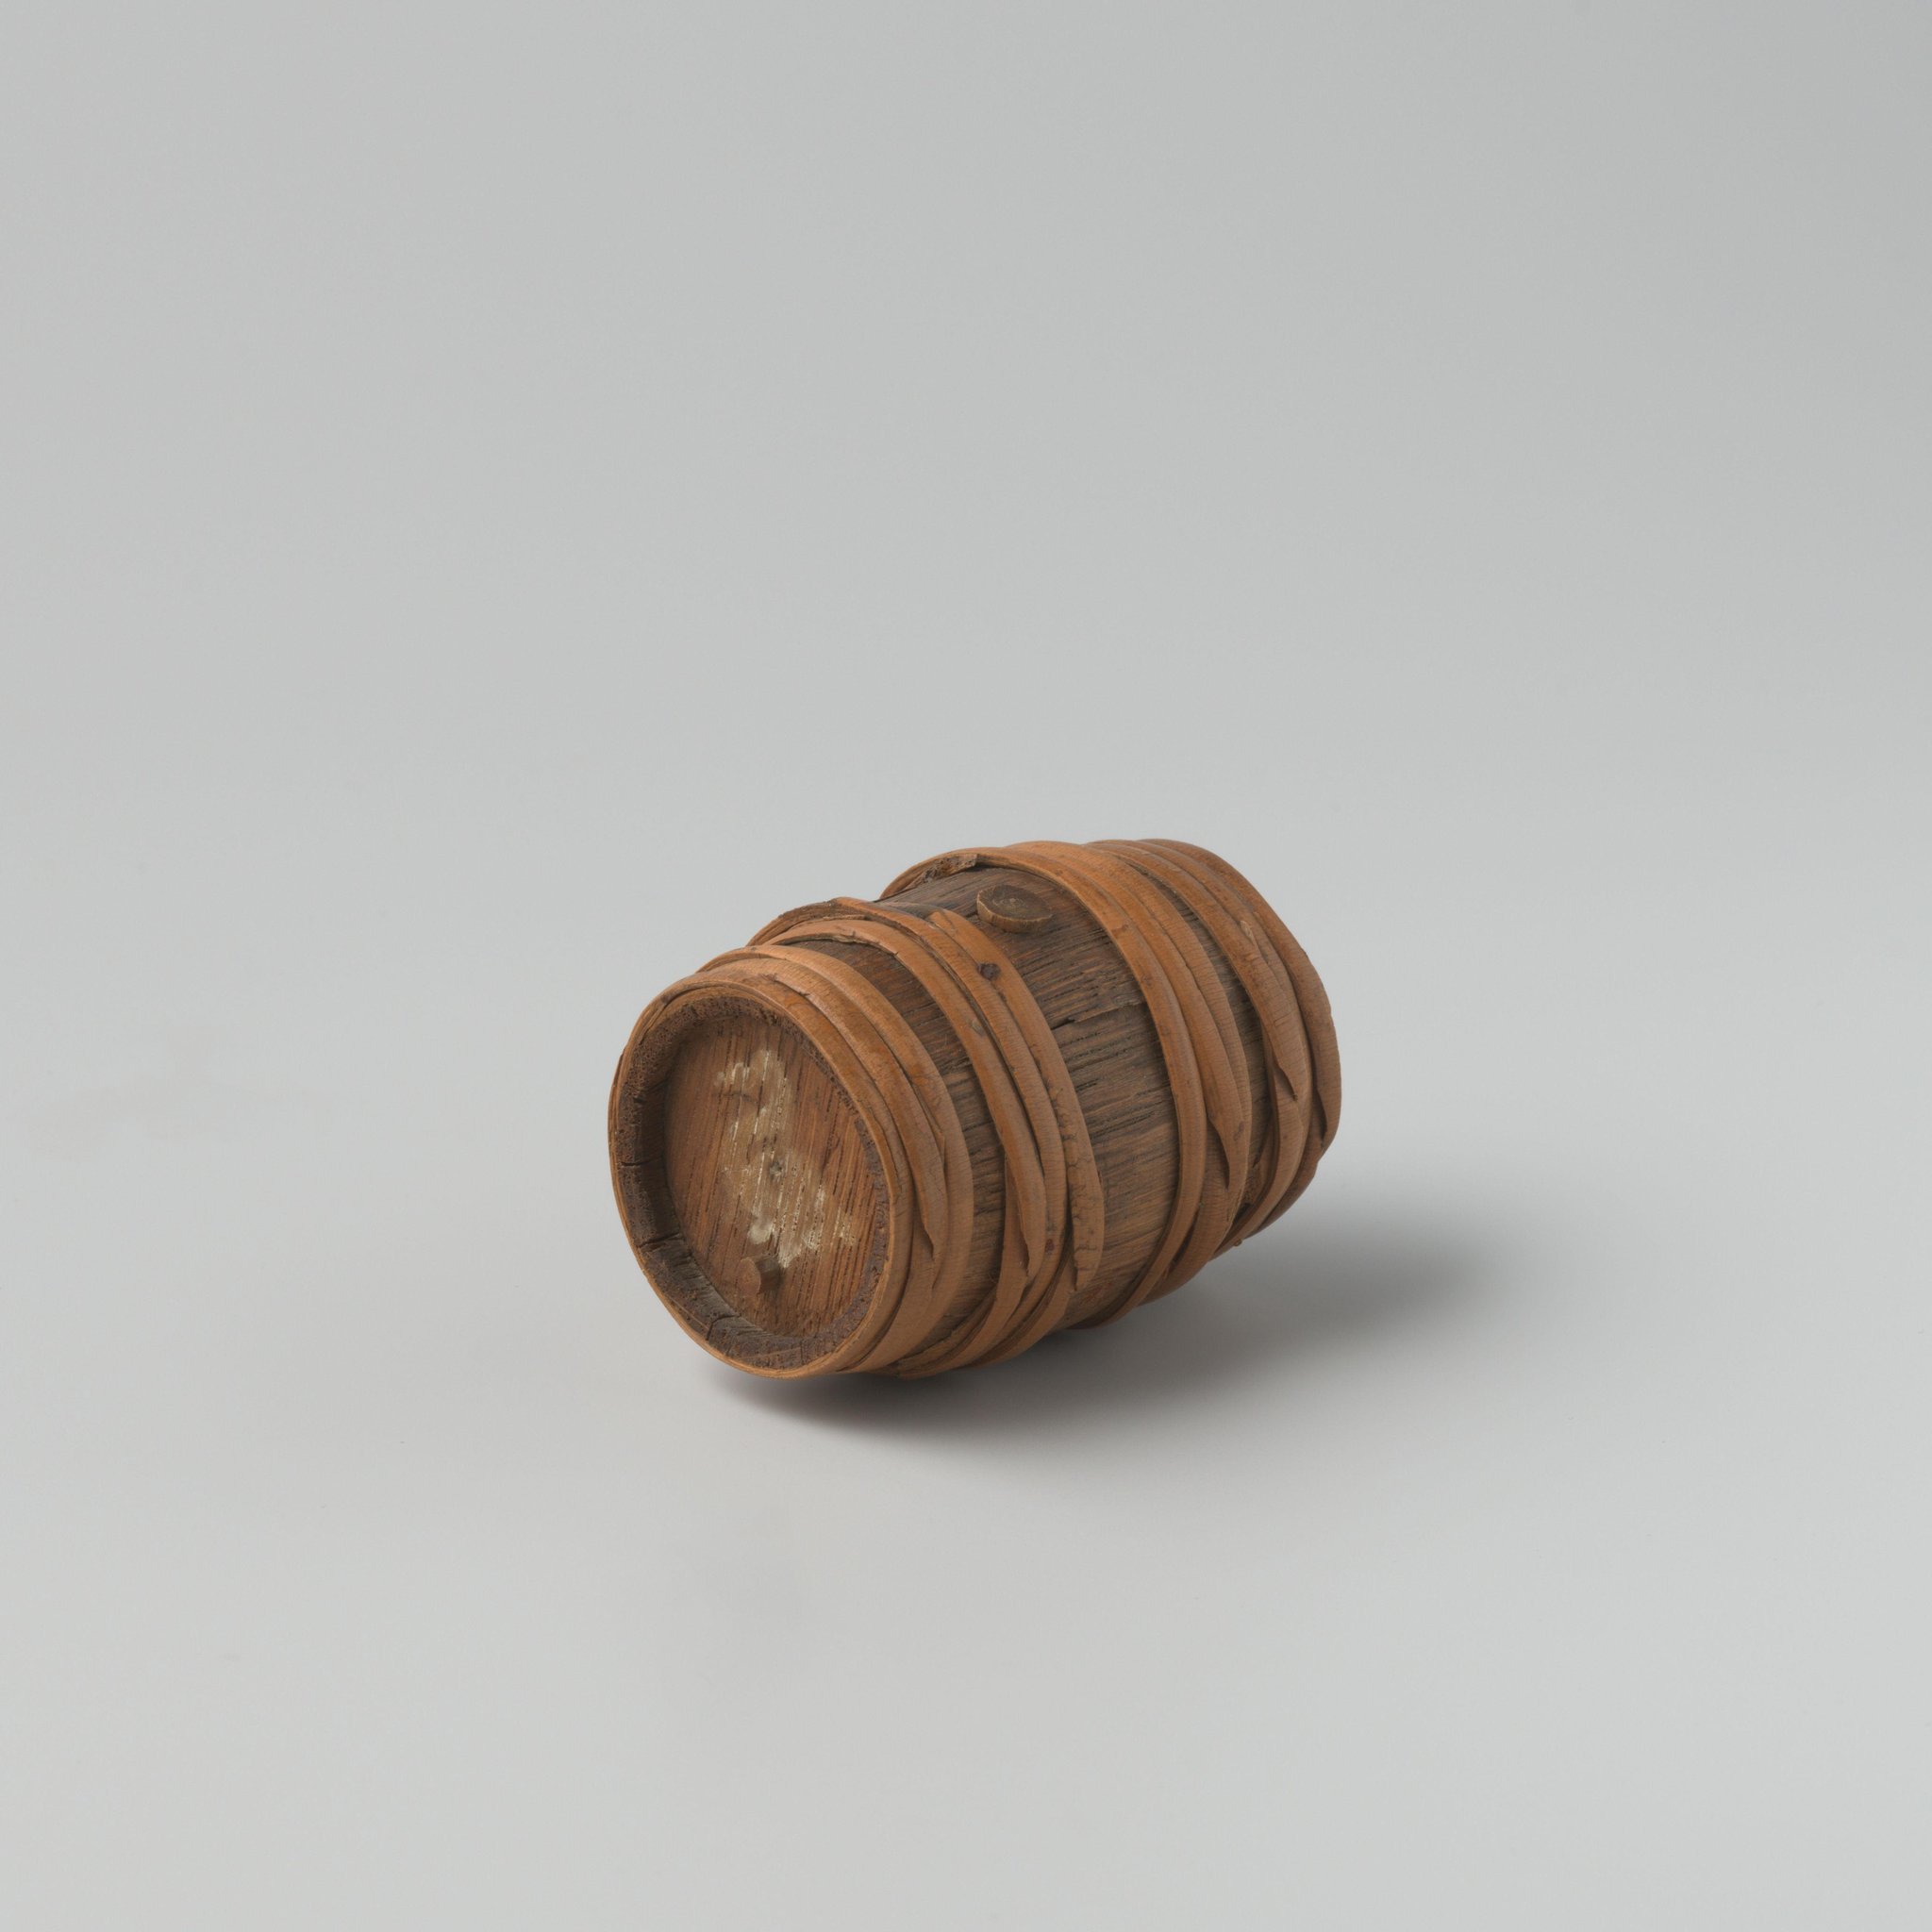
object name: vessel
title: Bier- of wijnvat, van eikenhouten duigen, omwonden door 4 x 3 hoepels van rotan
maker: Anonymous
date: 1690-1710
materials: brass, wood, rattan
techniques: gilding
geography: amsterdam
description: Bier- of wijnvat, van eikenhouten duigen, omwonden door 4 x 3 hoepels van rotan. Op de voorkant is met witte verf een zwaantje geschilderd.